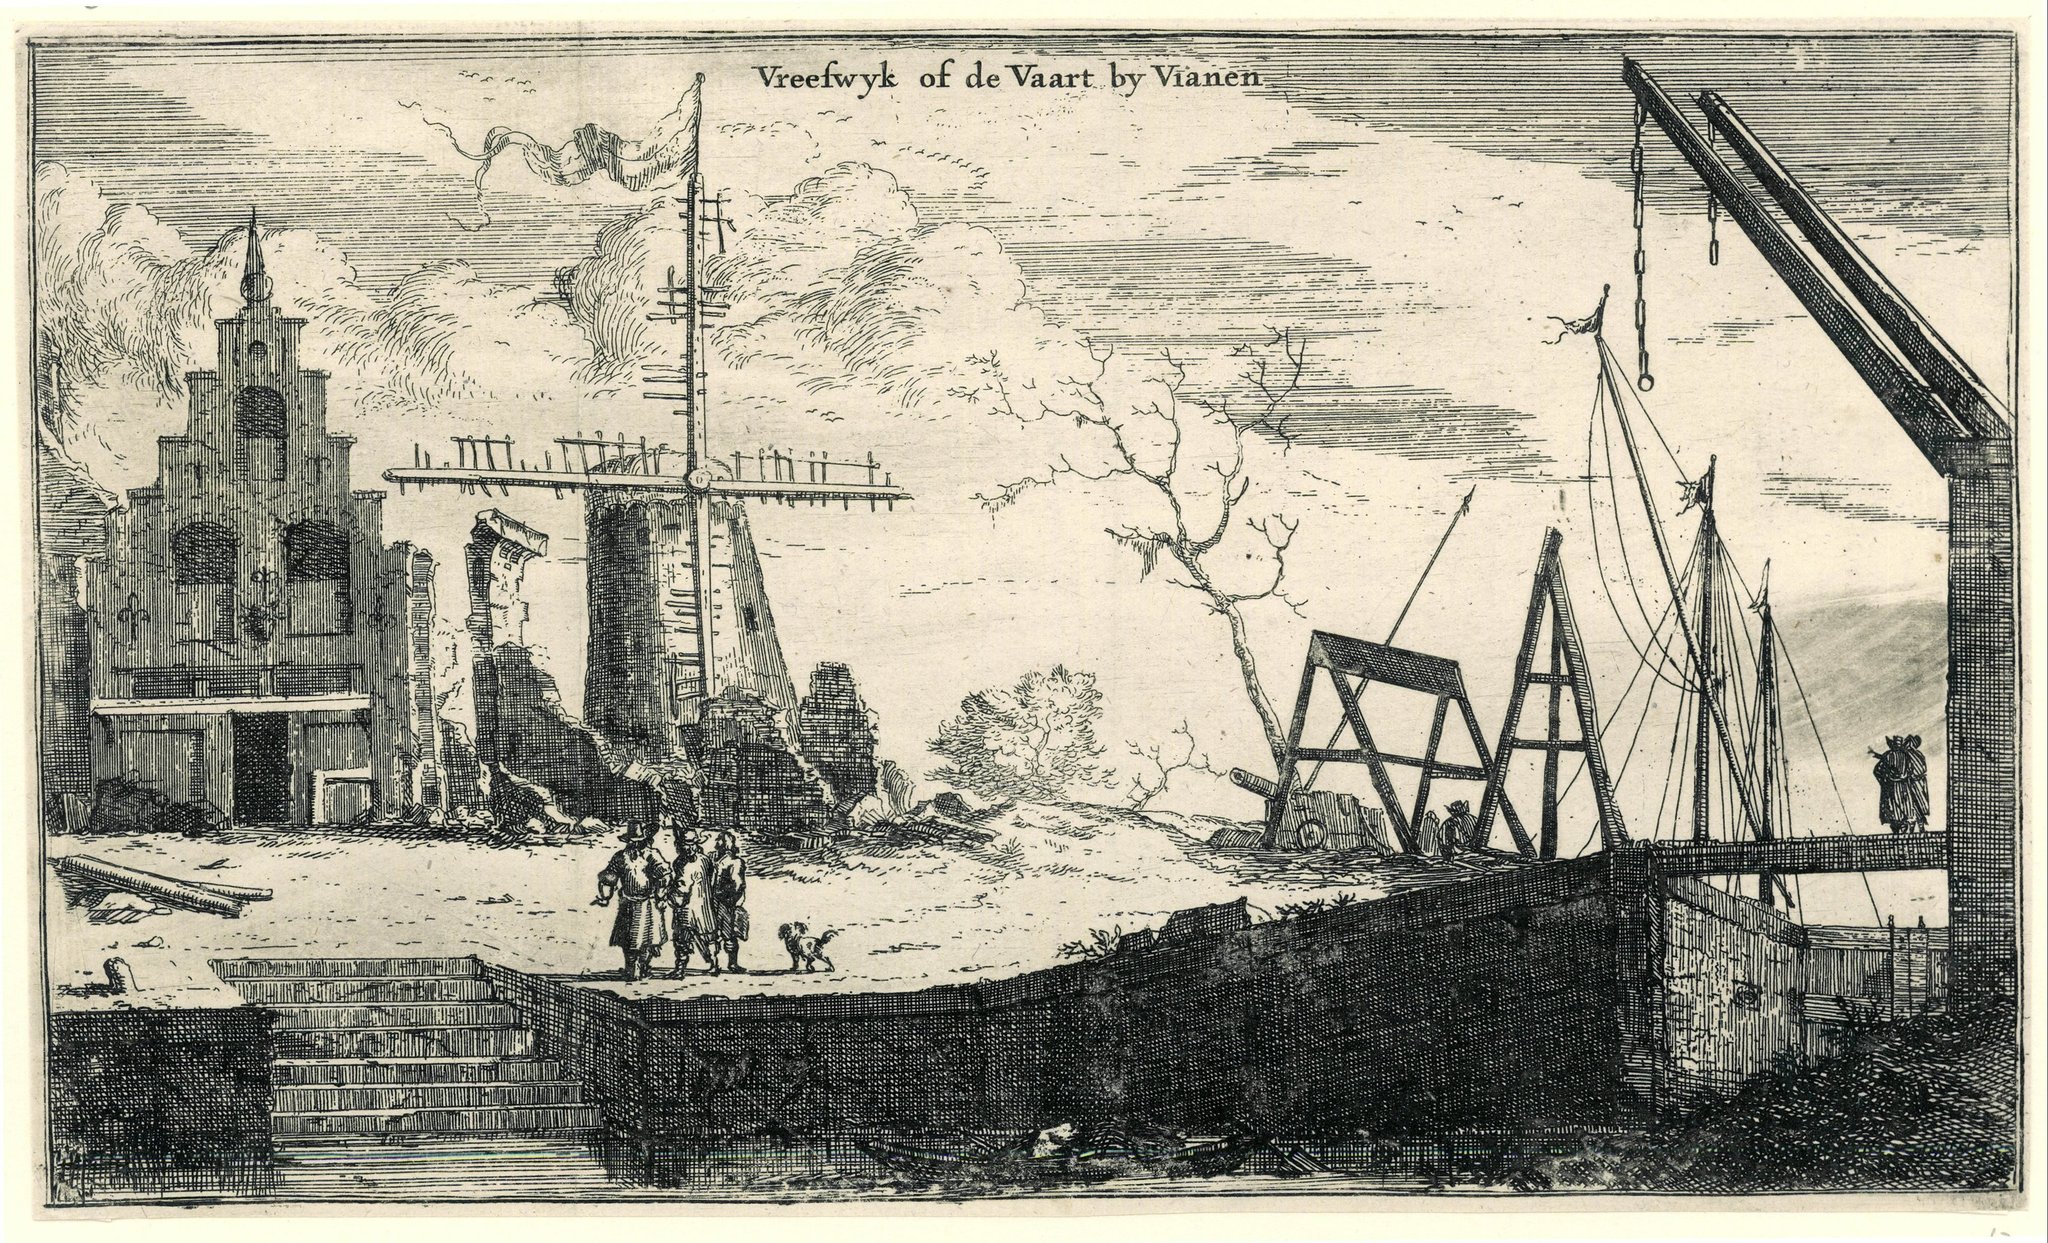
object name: history print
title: Reeks van dertien afbeeldingen van de dorpen en kastelen in de provincie Utrecht door de Fransen in 1672 verwoest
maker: isaac sorious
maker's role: print maker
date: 1672-1676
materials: paper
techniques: etching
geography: northern netherlands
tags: devastated, ruined place or city (~ warfare), rampjaar (disaster year)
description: Gebruikt als illustratie in: T. van Domselaer, Het Ontroerde Nederlandt, dl. II, Marcus Willemsz Doornick, Amsterdam 1676, p. 412/413. De reeks is ook als een losse serie uitgegeven met een titelprent die niet in het boek is opgenomen.